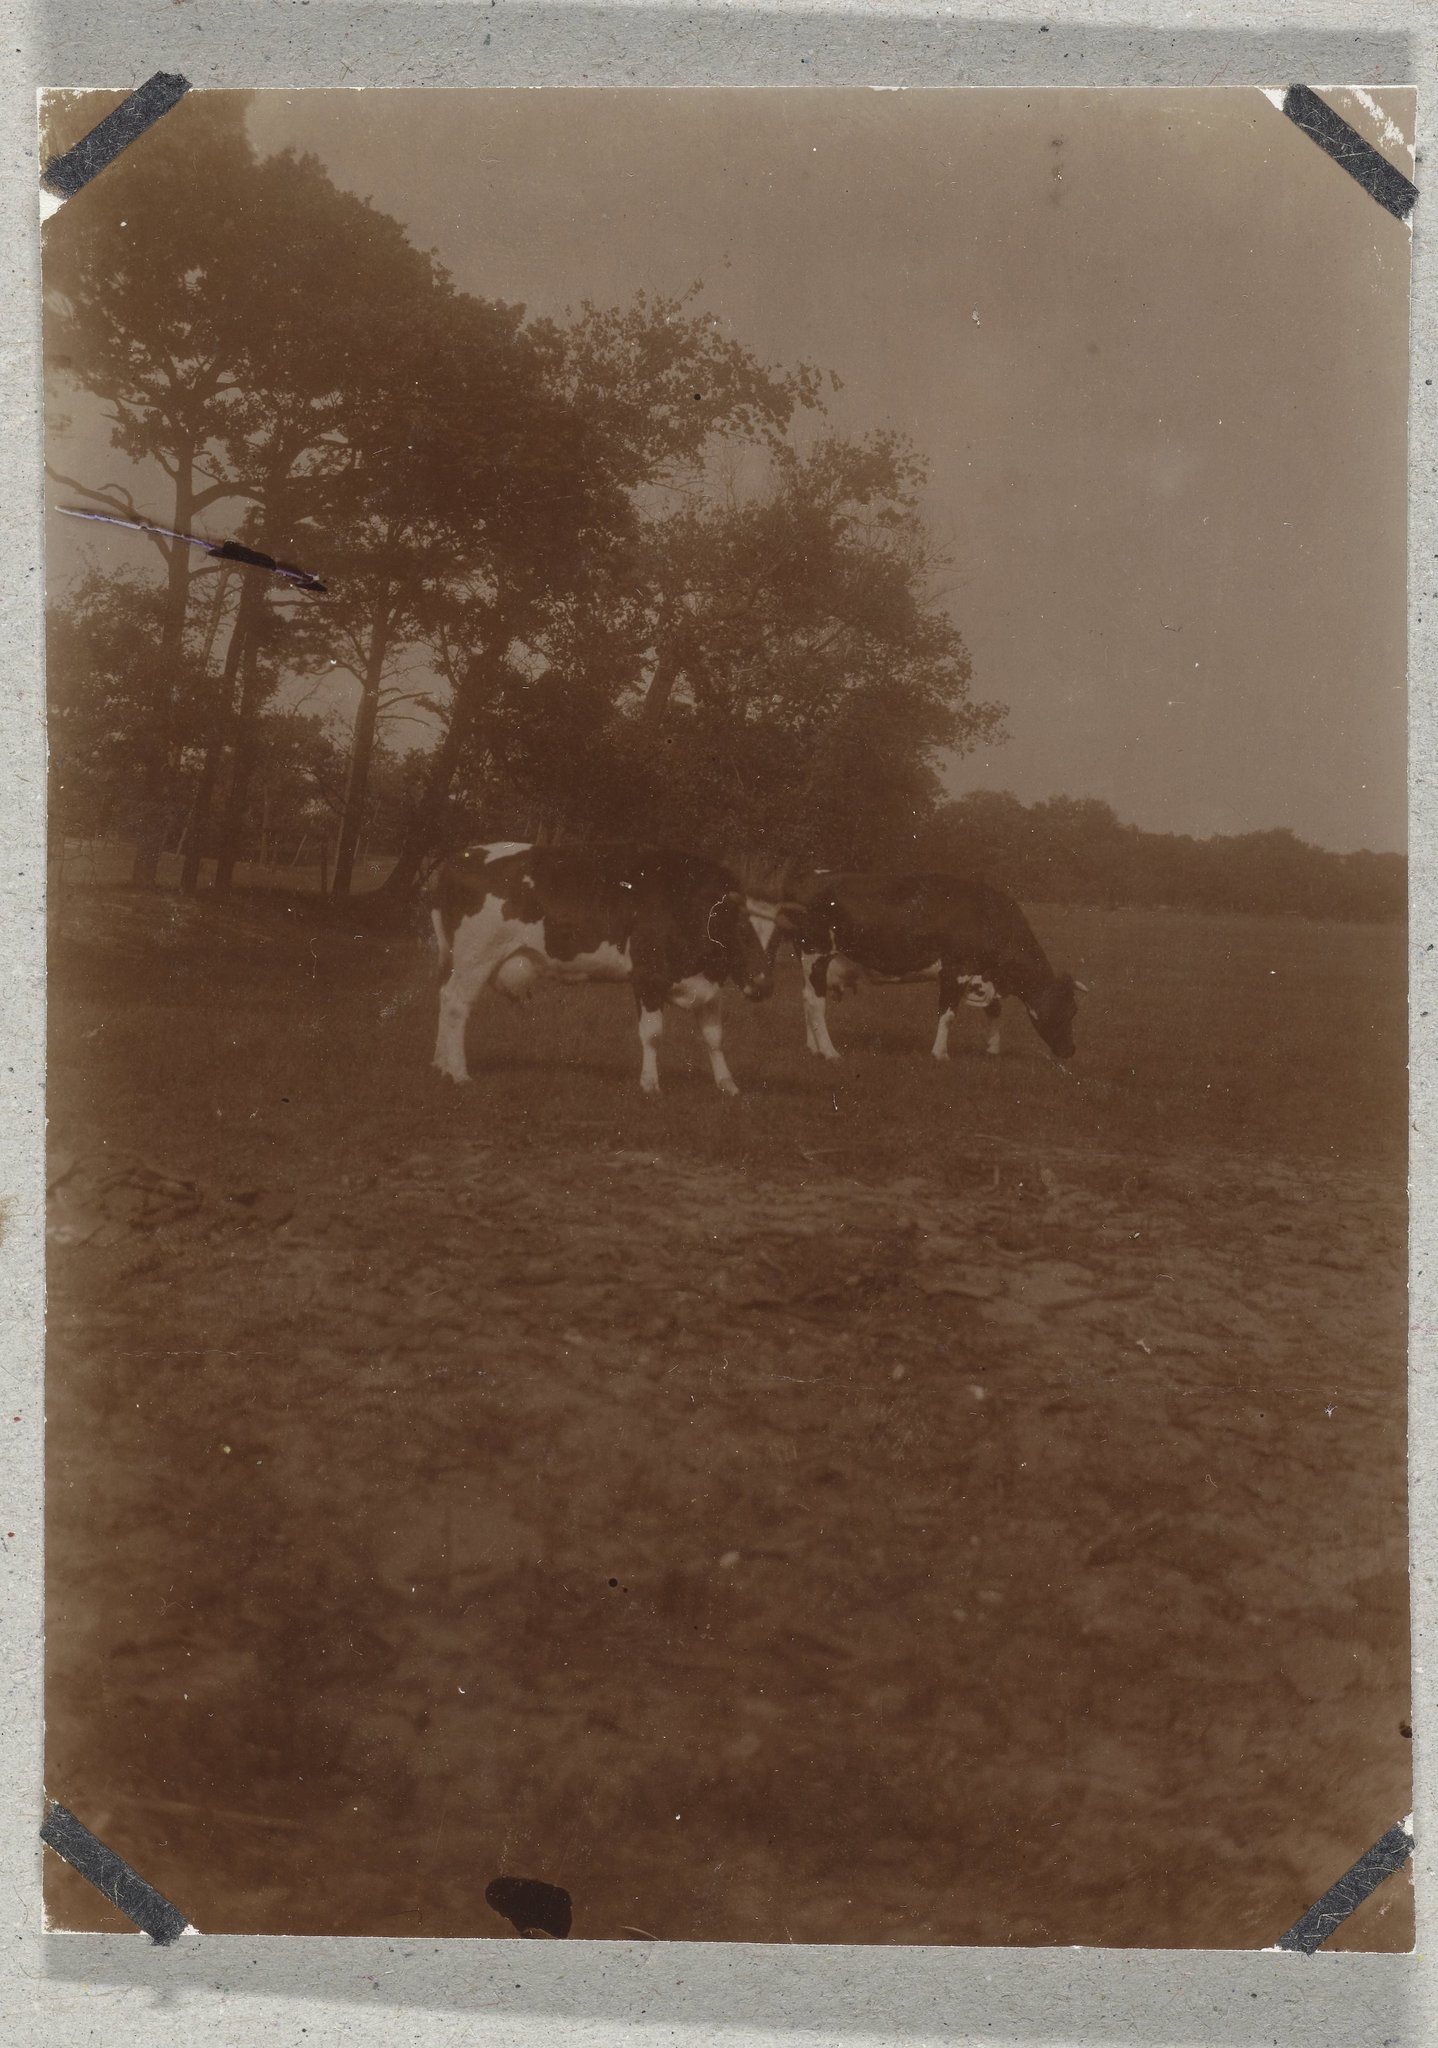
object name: photograph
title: Koeien in het Meijendel bij Wassenaar en Den Haag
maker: Anonymous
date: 1923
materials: photographic support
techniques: collodion silver print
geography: netherlands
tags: cow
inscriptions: annotation: ‘Koeien bij Meyendel / 23 Juli 1923 / matige zon / 1/25 sec. Focus 5,4 / "Gem" plaat.’